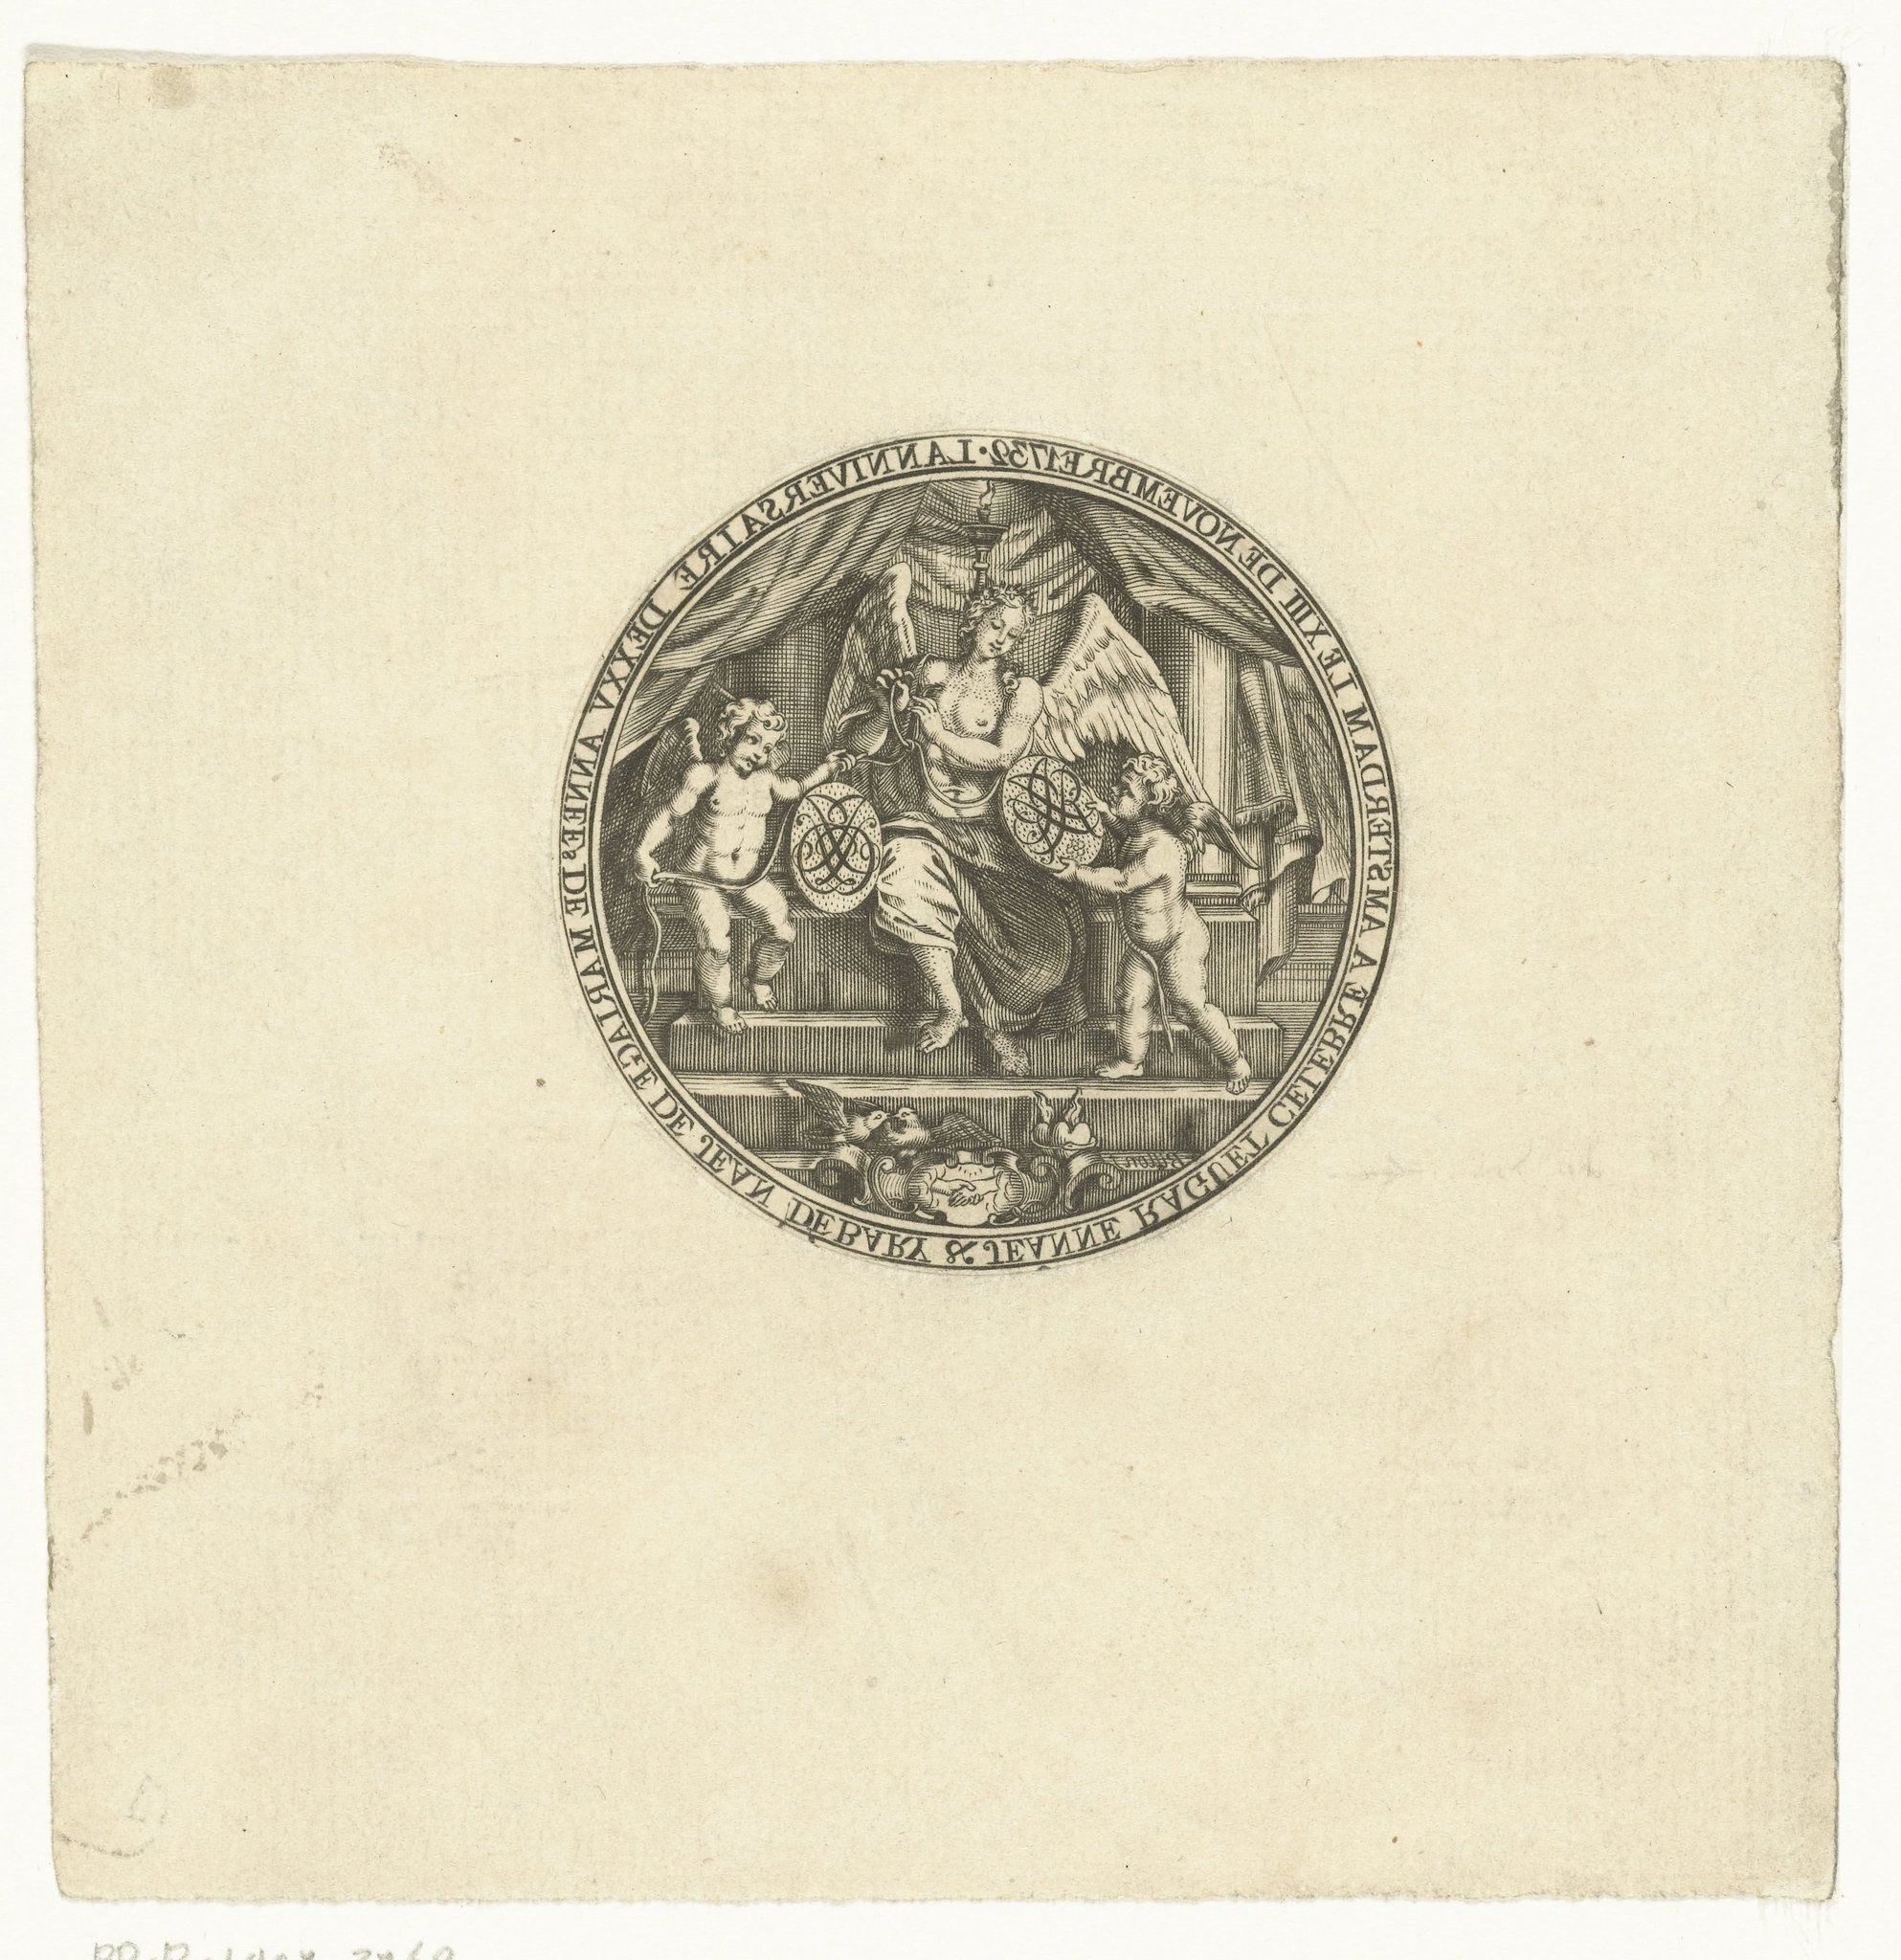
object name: print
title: Penning met naakte gevleugelde vrouw en twee cupido's en symbolen van liefde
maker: billon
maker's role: print maker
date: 1732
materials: paper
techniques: engraving, etching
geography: netherlands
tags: shaking hands, 'dextrarum junctio', other birds: turtle dove, abstract ideas and concepts (+ partially clothed with wings), cupids: 'amores', 'amoretti', 'putti', profane heart symbolism ~ love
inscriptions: inscription: ‘Lanniversaire de XXV annees de mariage de Jean de Bary & Jeanne Raguet celebre a Amsterdam le XIII de novembre 1732’, collector's mark: Lugt 2228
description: Een naakte gevleugelde vrouw troont op een voetstuk en krijgt twee schilden met initialen van geliefden aangereikt door twee cupido's. Zij knoopt de touwen van de schilden aan elkaar als symbool van hun huwelijk. Huwelijkse trouw en liefde wordt tot uiting gebracht door twee tortelduiven, twee brandende harten en een schild met twee elkaar vastpakkende handen. Volgens het opschrift is deze penning vervaardigd ter gelegenheid van het vijfentwintig jarig huwelijk van Jan de Barij en Jeanne Raguet dat werd gevierd te Amsterdam op 13 november 1732.